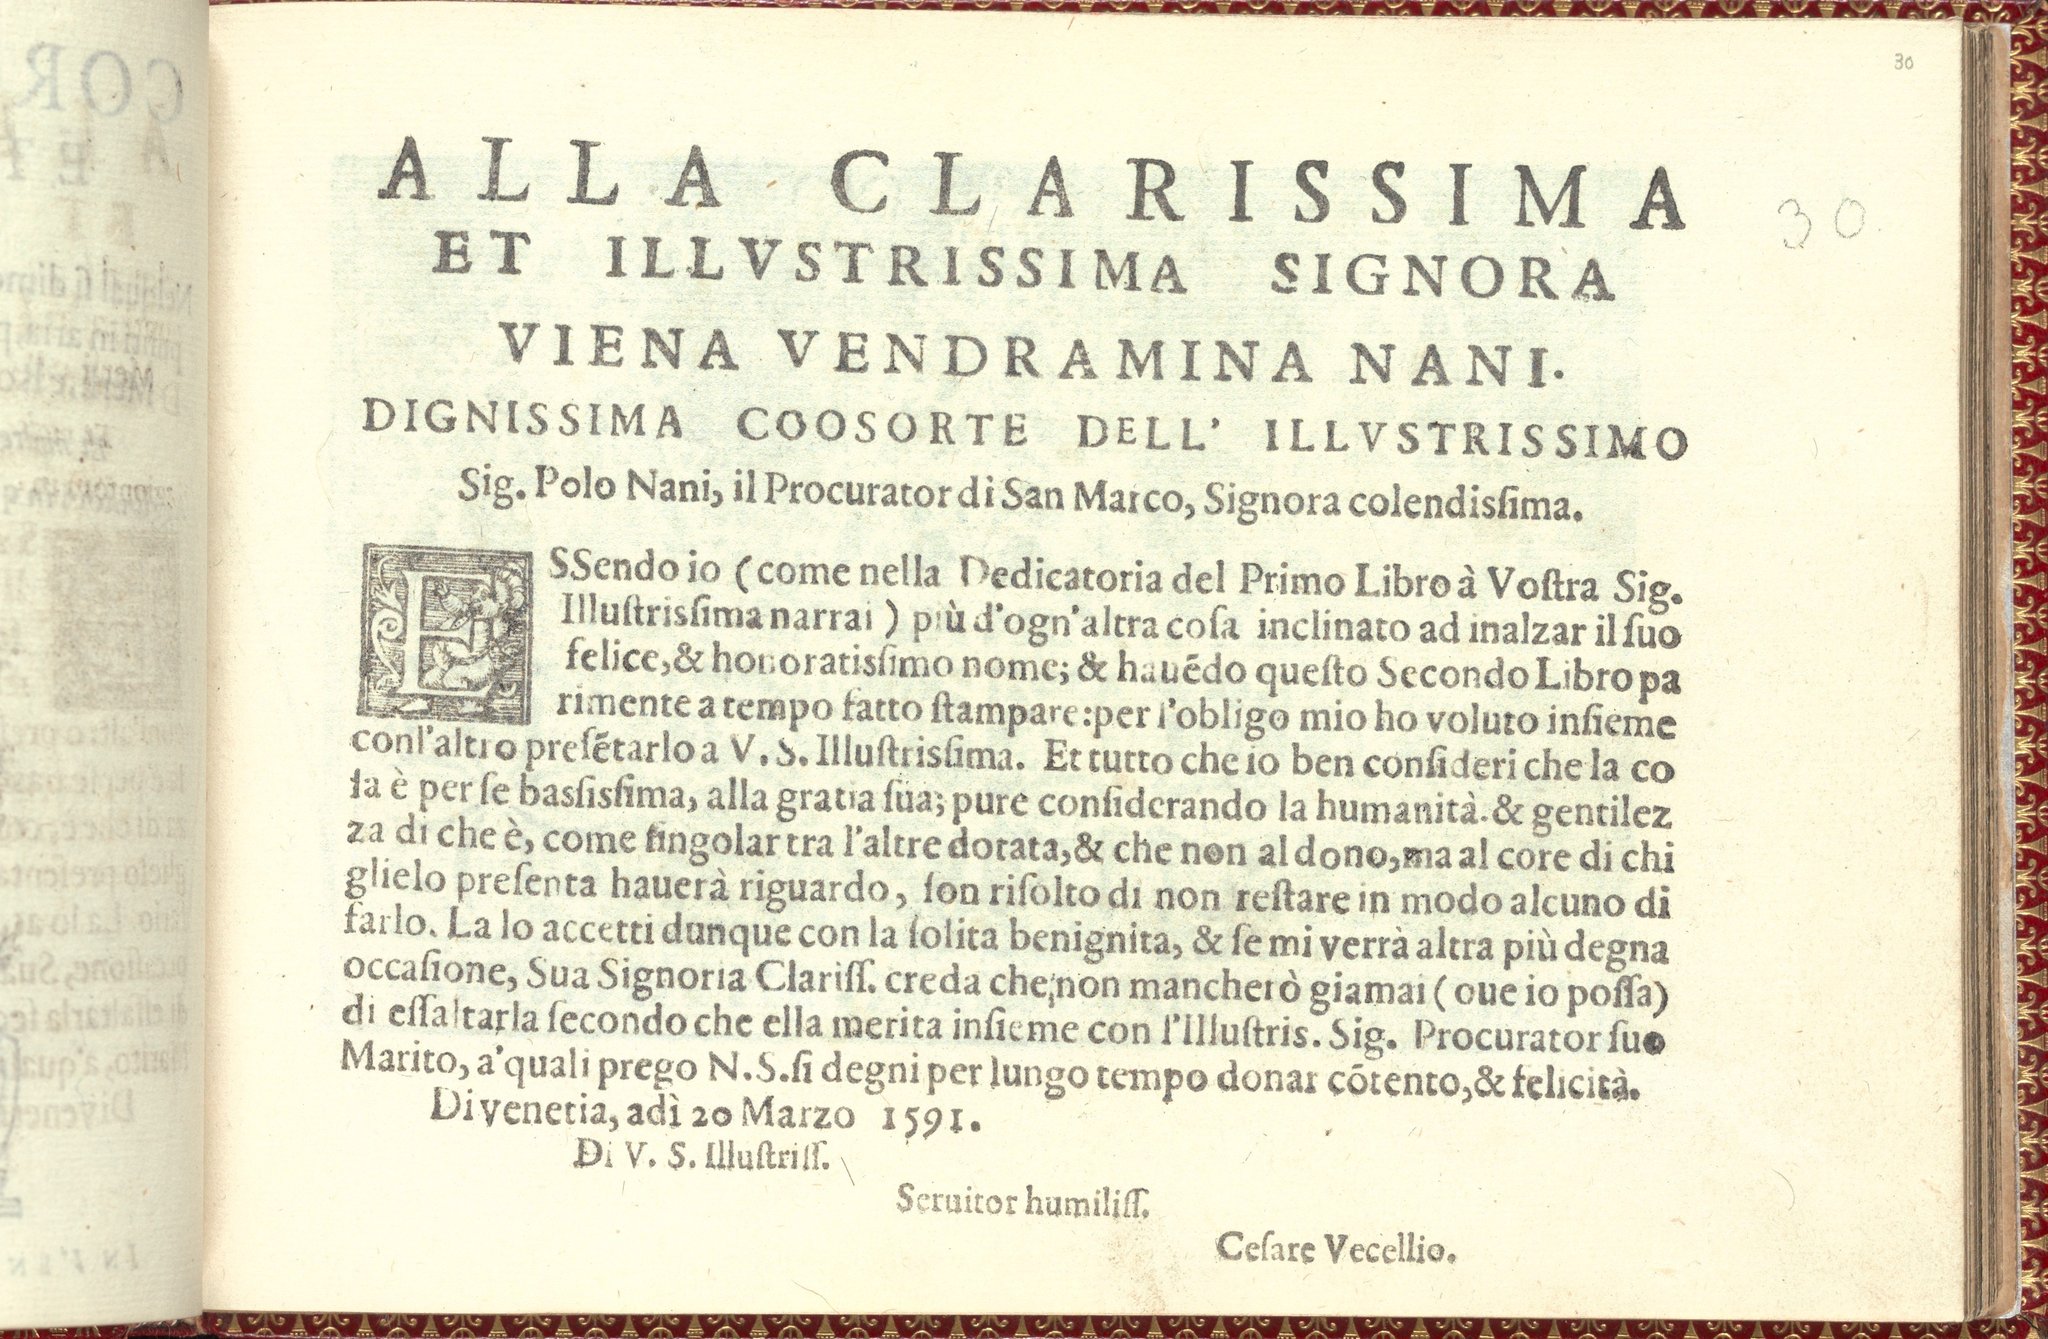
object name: book print ornament architecture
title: Corona delle Nobili et Virtuose Donne: Libro I-IV, page 30 (recto)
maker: cesare vecellio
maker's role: publisher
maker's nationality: italian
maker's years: 1521-1601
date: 1601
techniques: woodcut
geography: italy